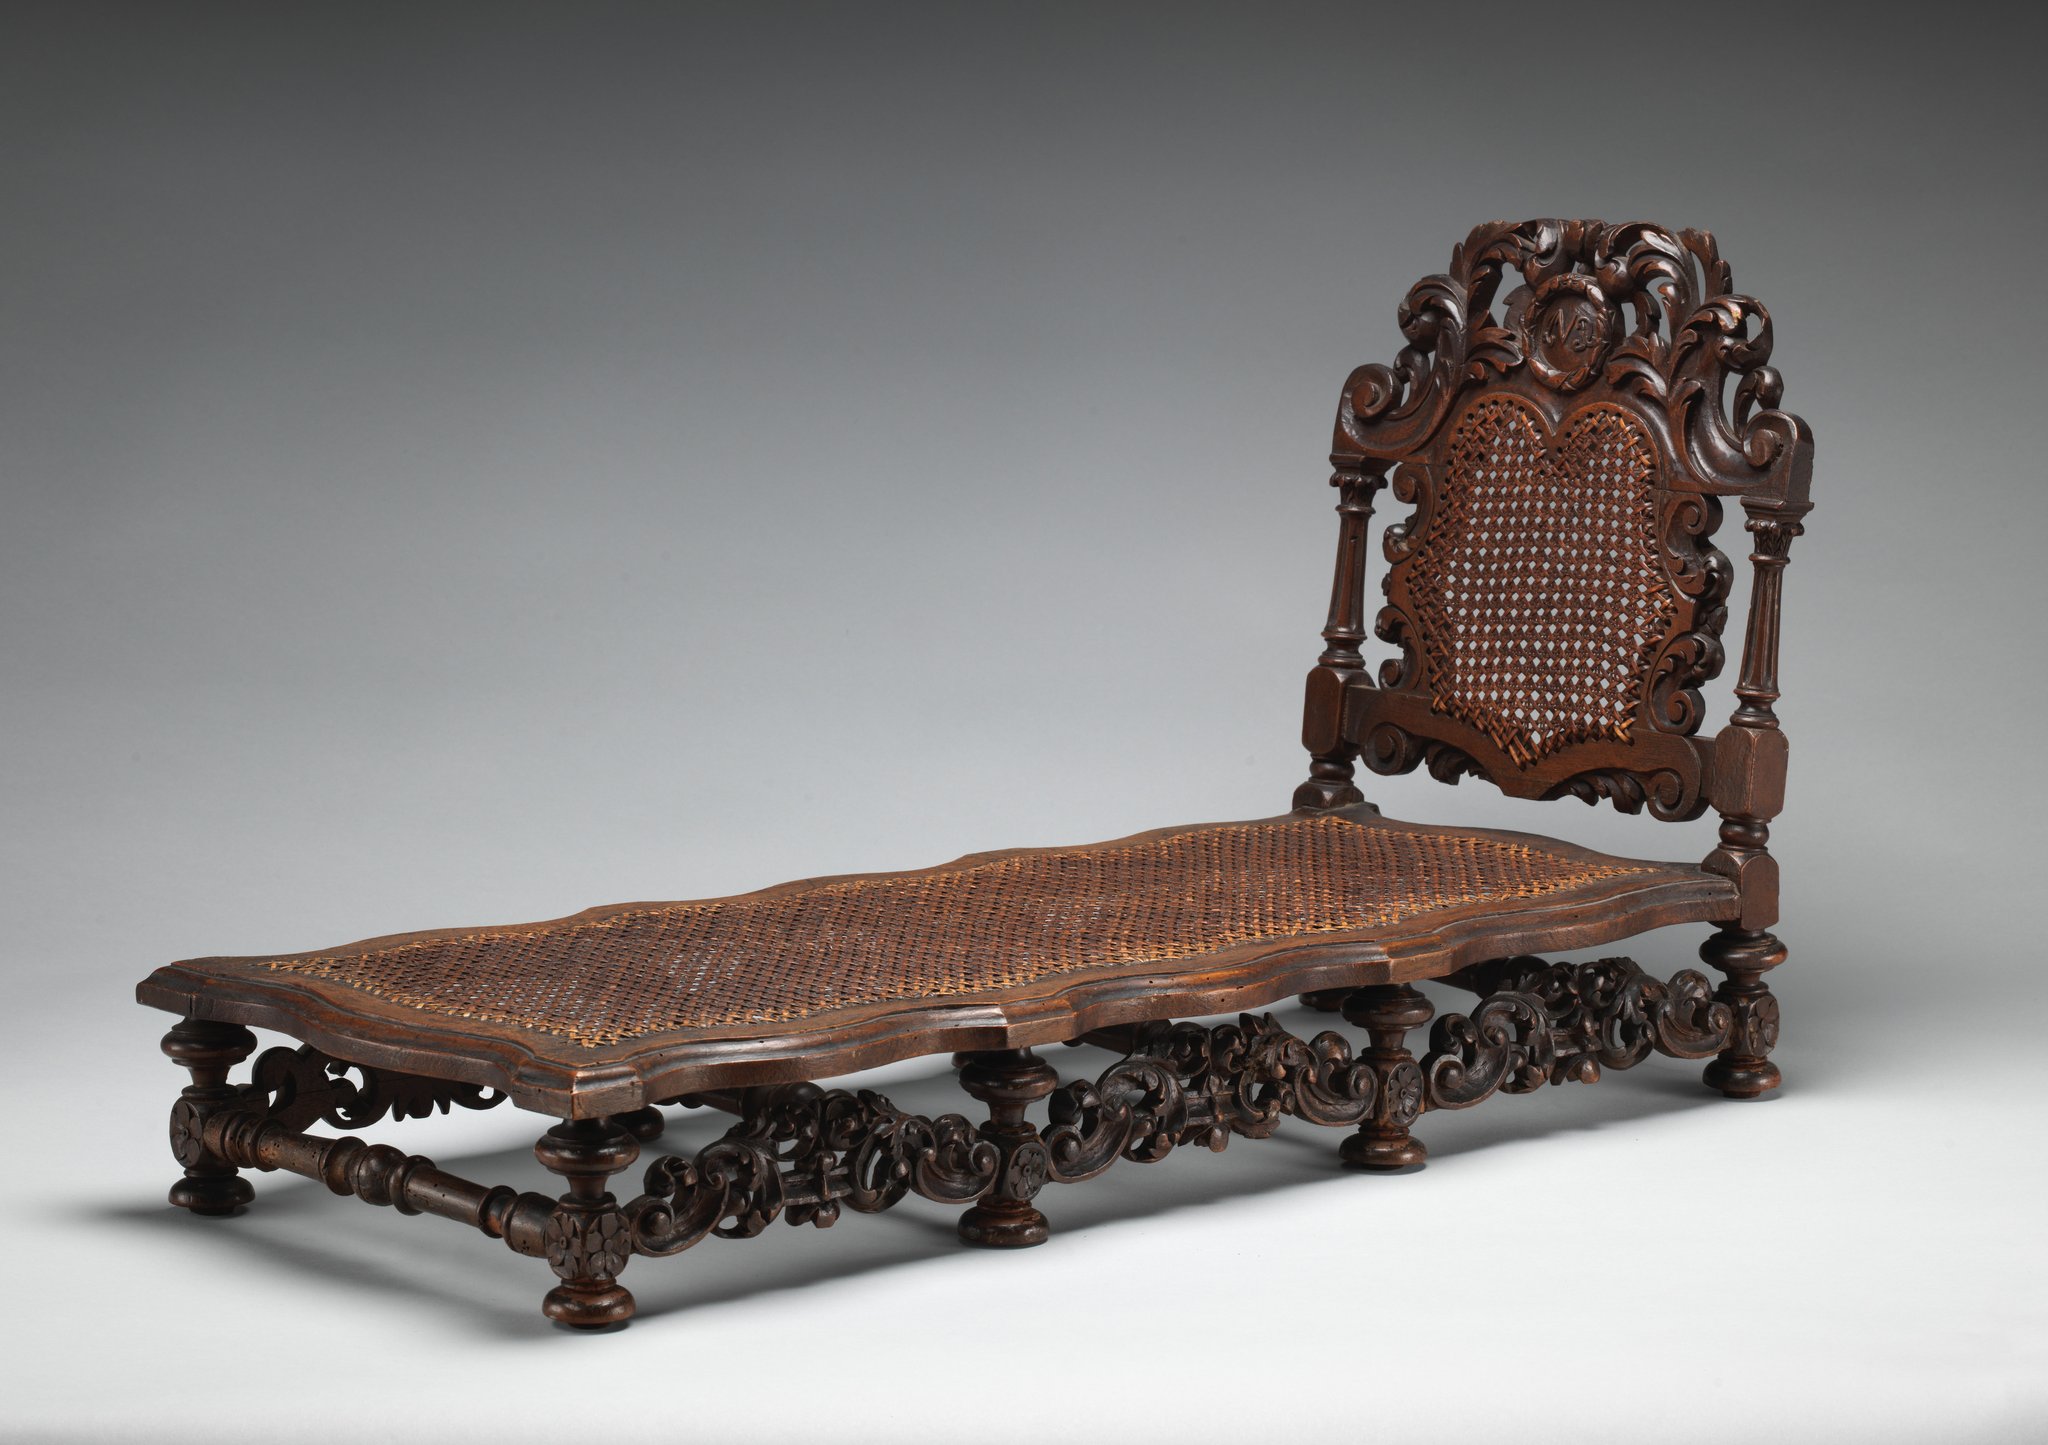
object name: daybed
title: Miniature daybed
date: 1689-1702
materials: wood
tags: beds